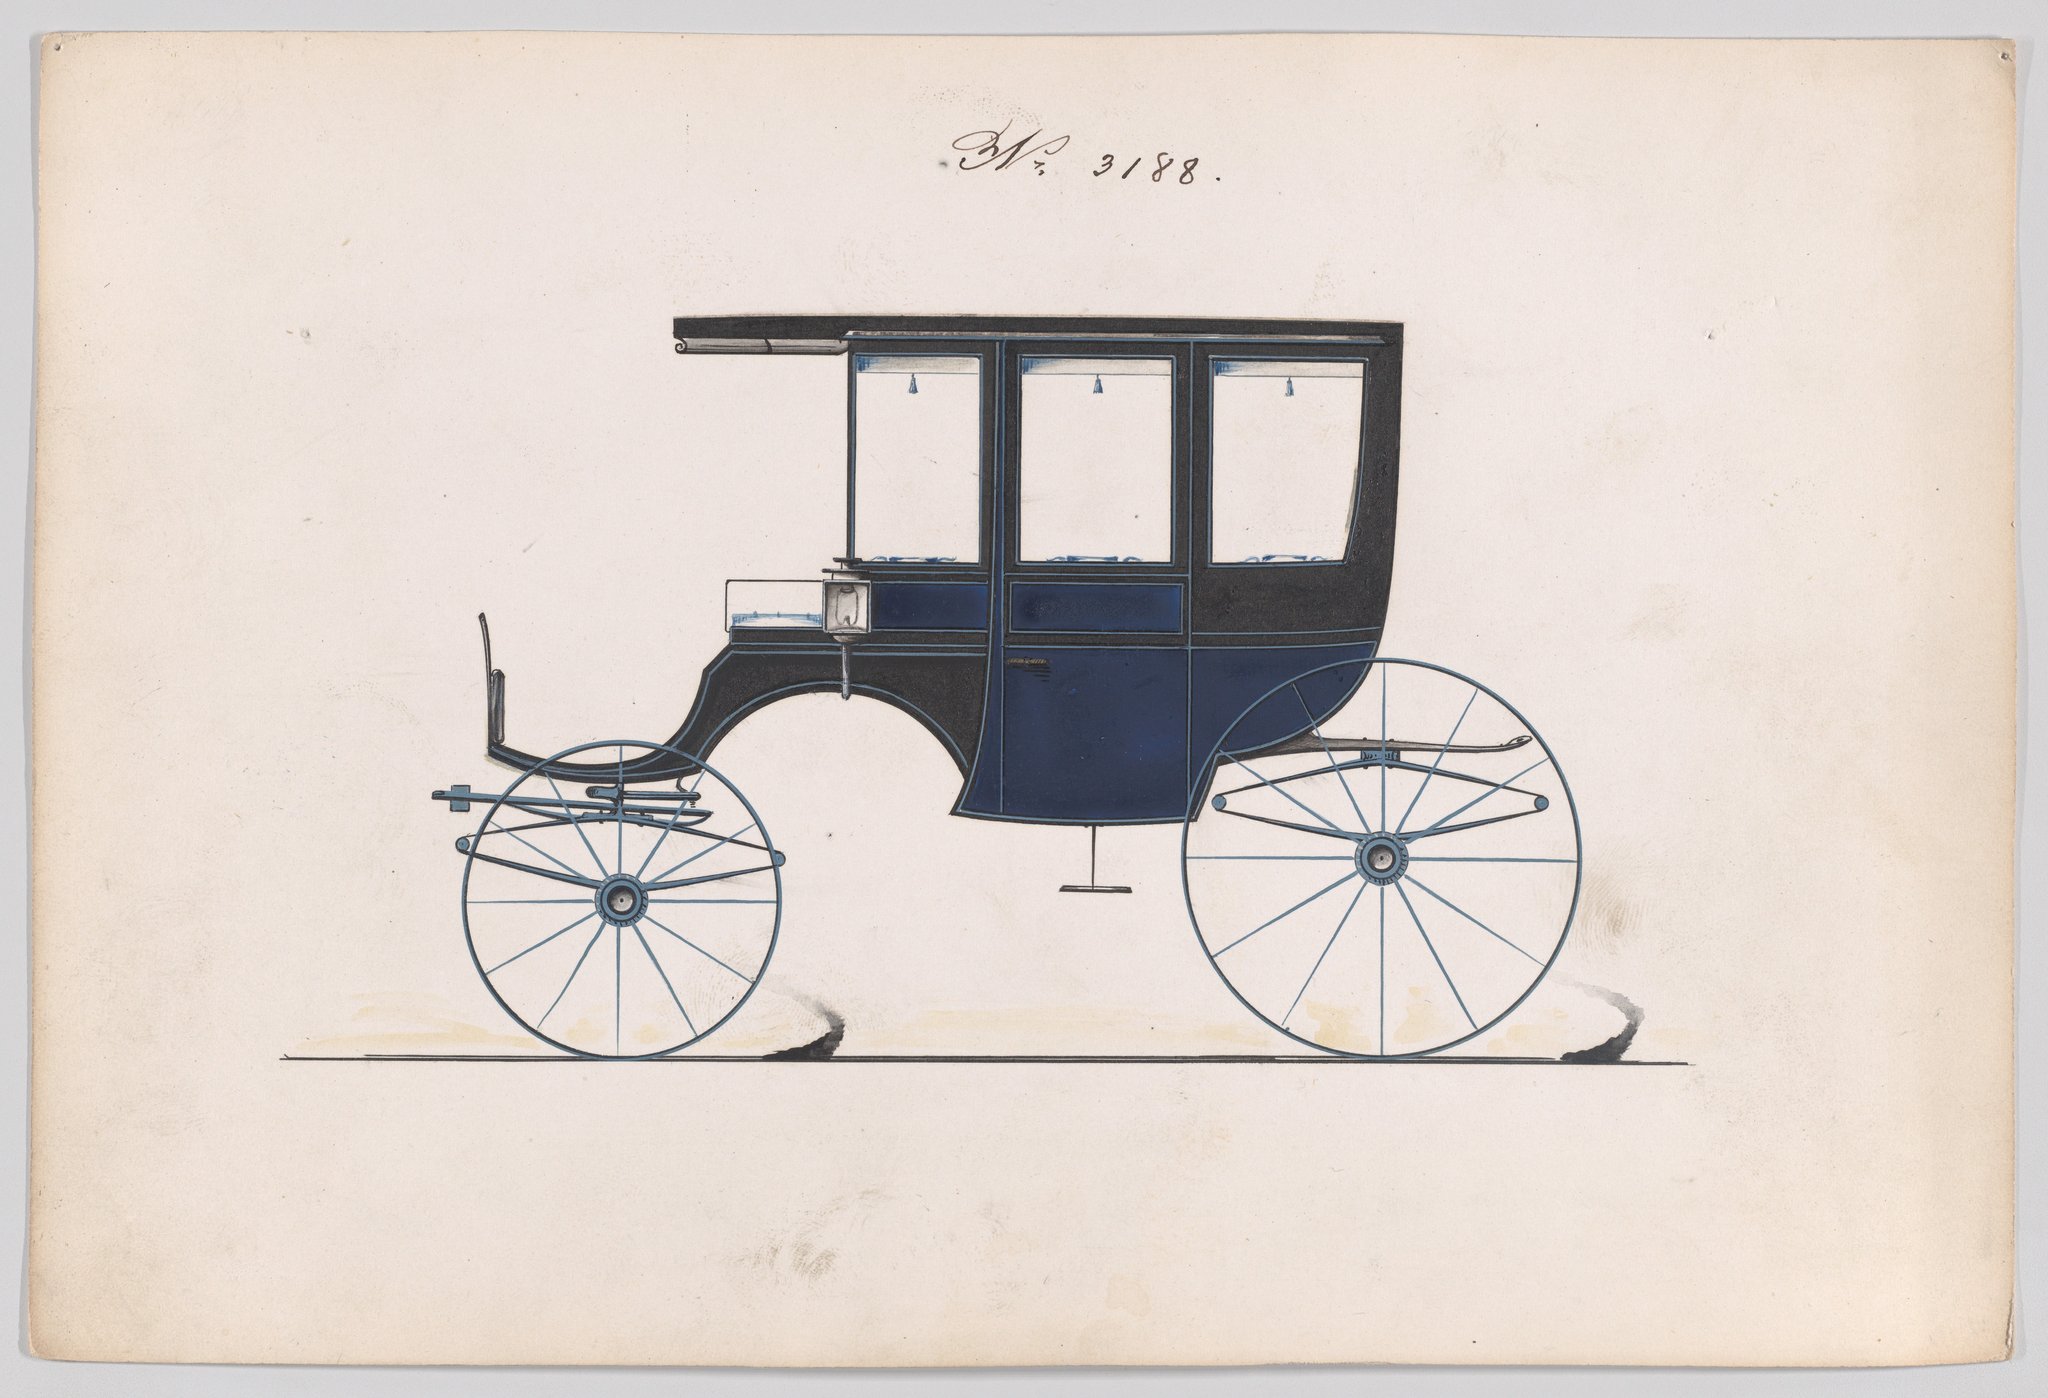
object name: drawing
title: Design for 6 seat Rockaway, no. 3188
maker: brewster & co.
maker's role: manufacturer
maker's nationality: american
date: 1876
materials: gouache, ink, watercolor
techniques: pen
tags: carriages